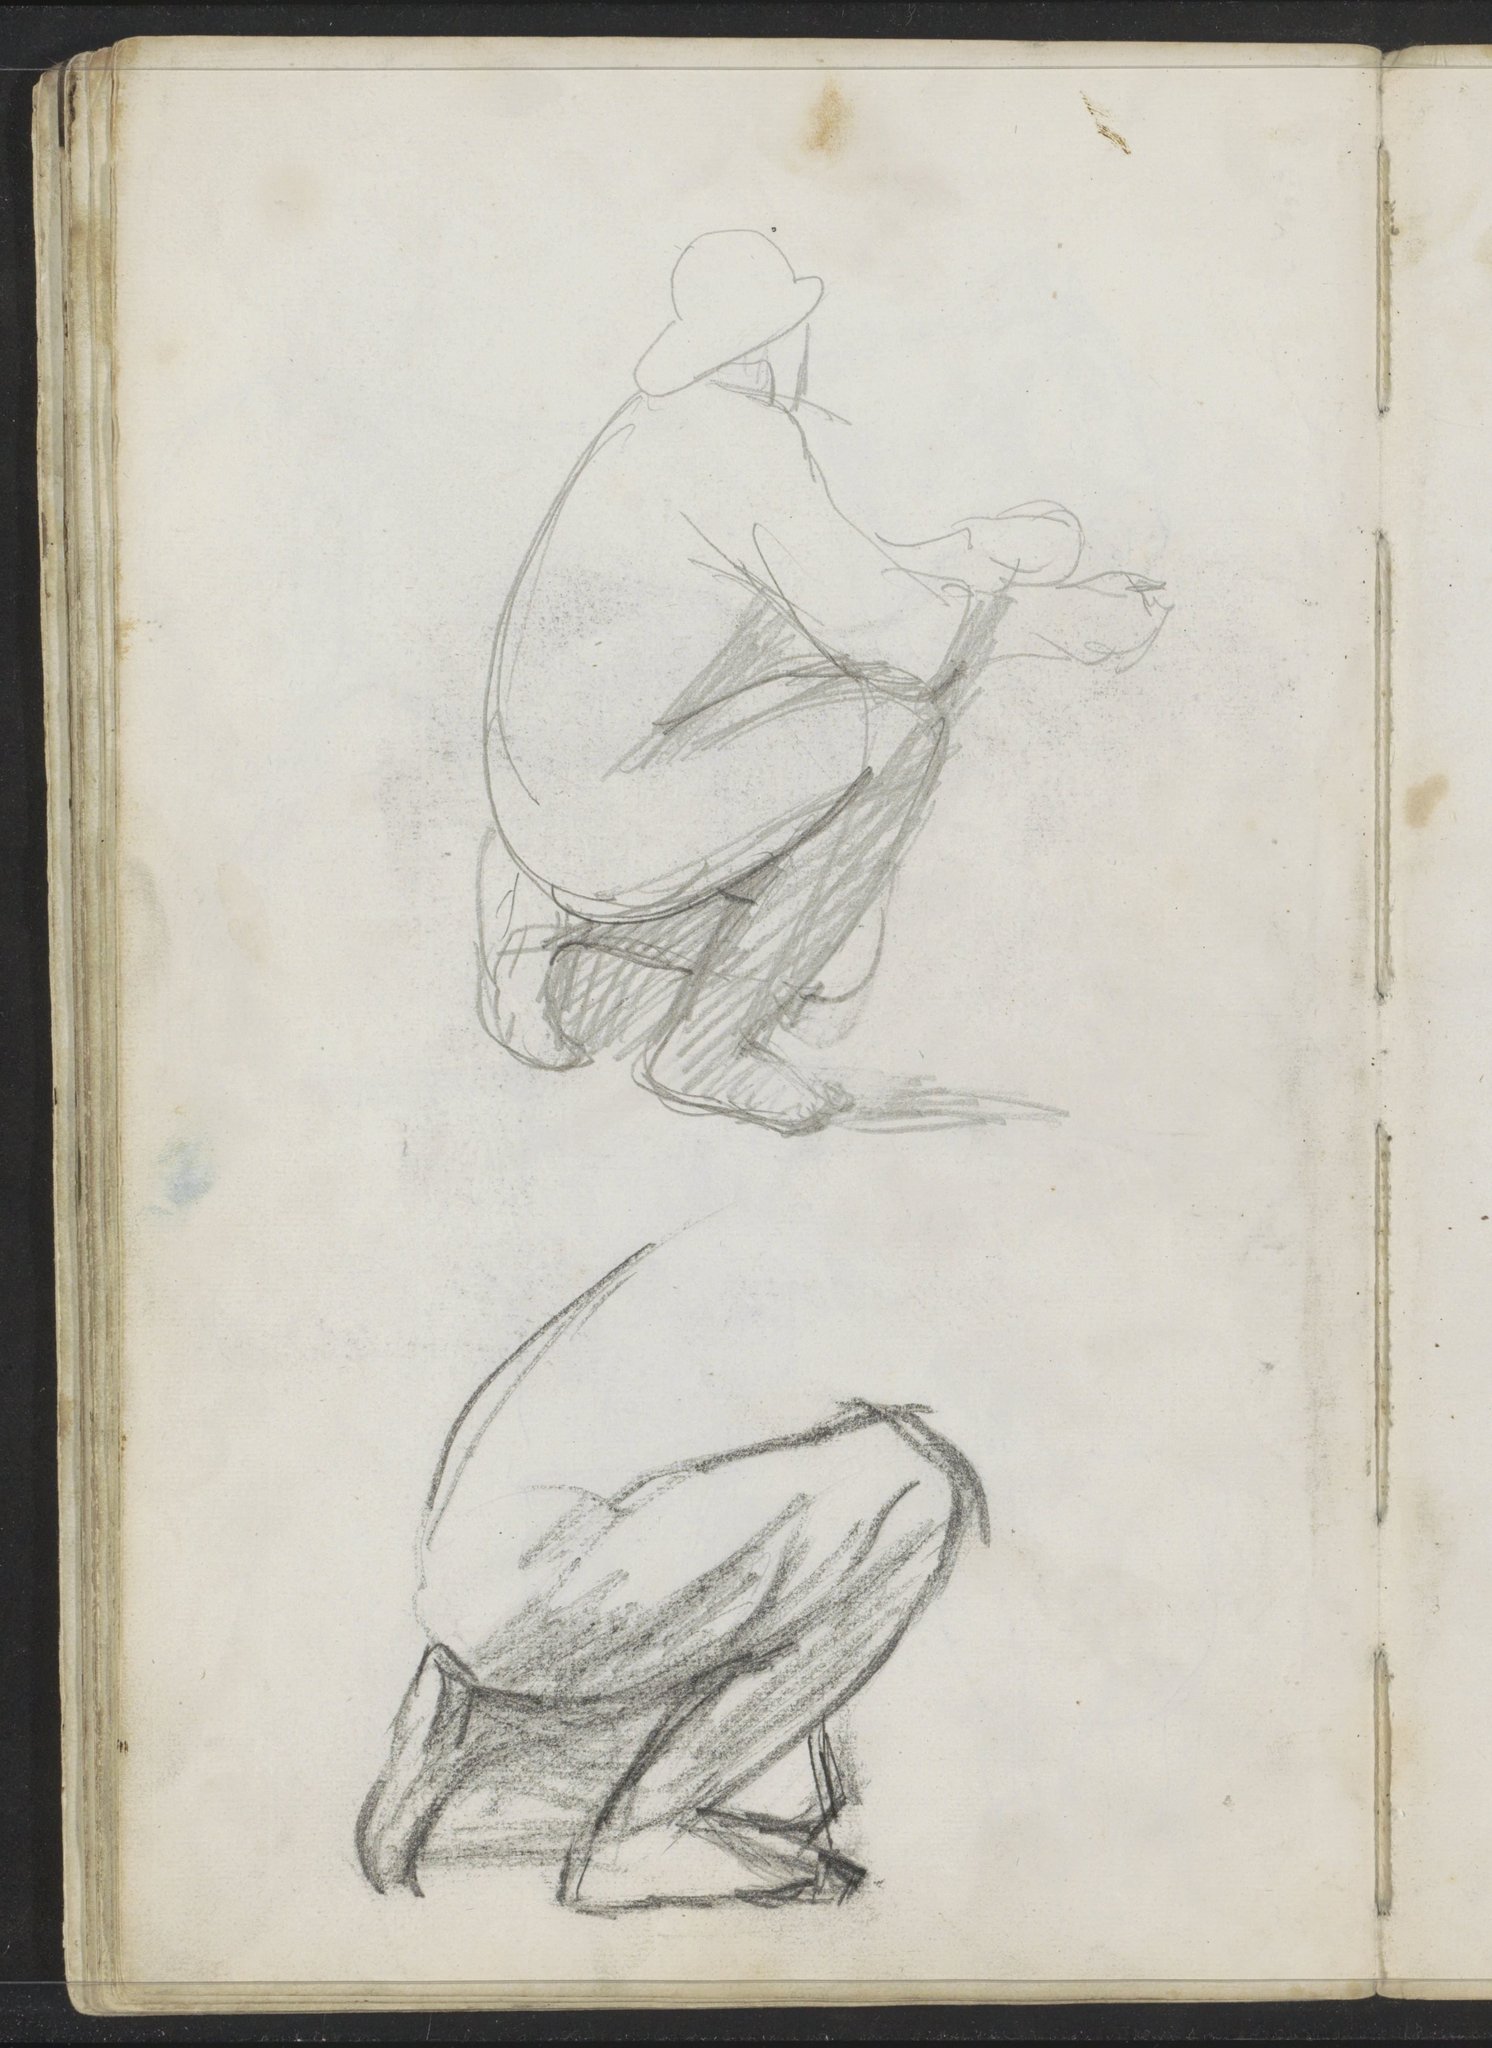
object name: sketchbook leaf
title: Hurkende man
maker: jozef israëls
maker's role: draughtsman, painter, print maker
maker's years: 1824-1911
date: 1855-1859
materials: paper, pencil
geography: zandvoort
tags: squatting, crouching figure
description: Blad 20 verso uit een schetsboek met 22 bladen.